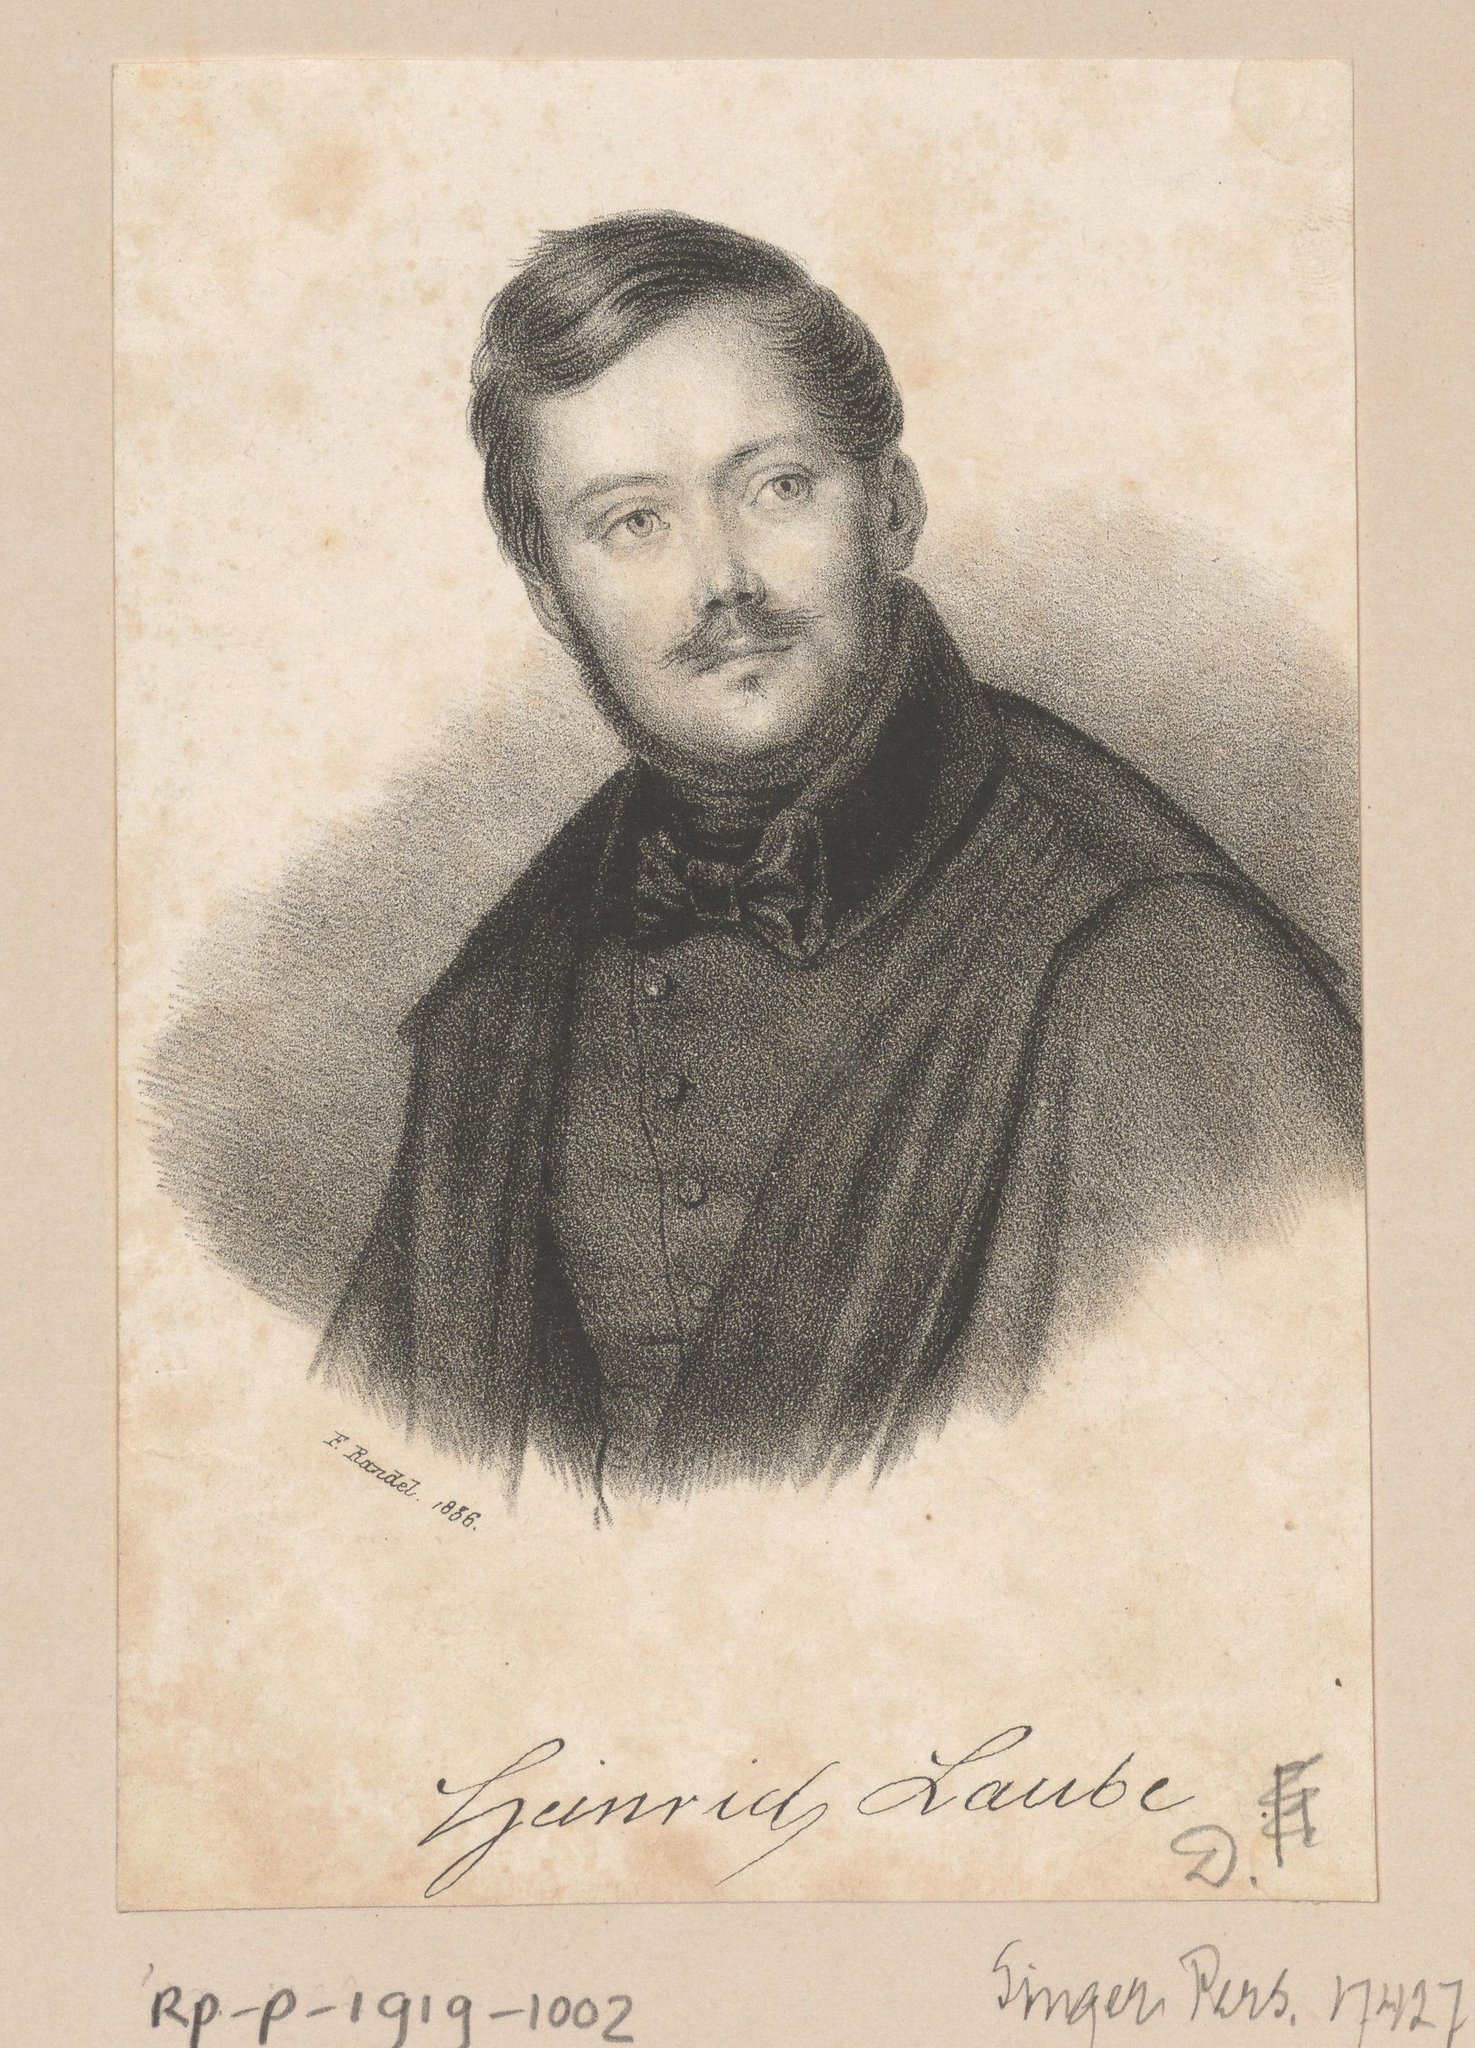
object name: print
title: Portret van Heinrich Laube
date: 1836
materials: paper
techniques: lithograph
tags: vienna, historical persons, portrait of a writer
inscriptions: date